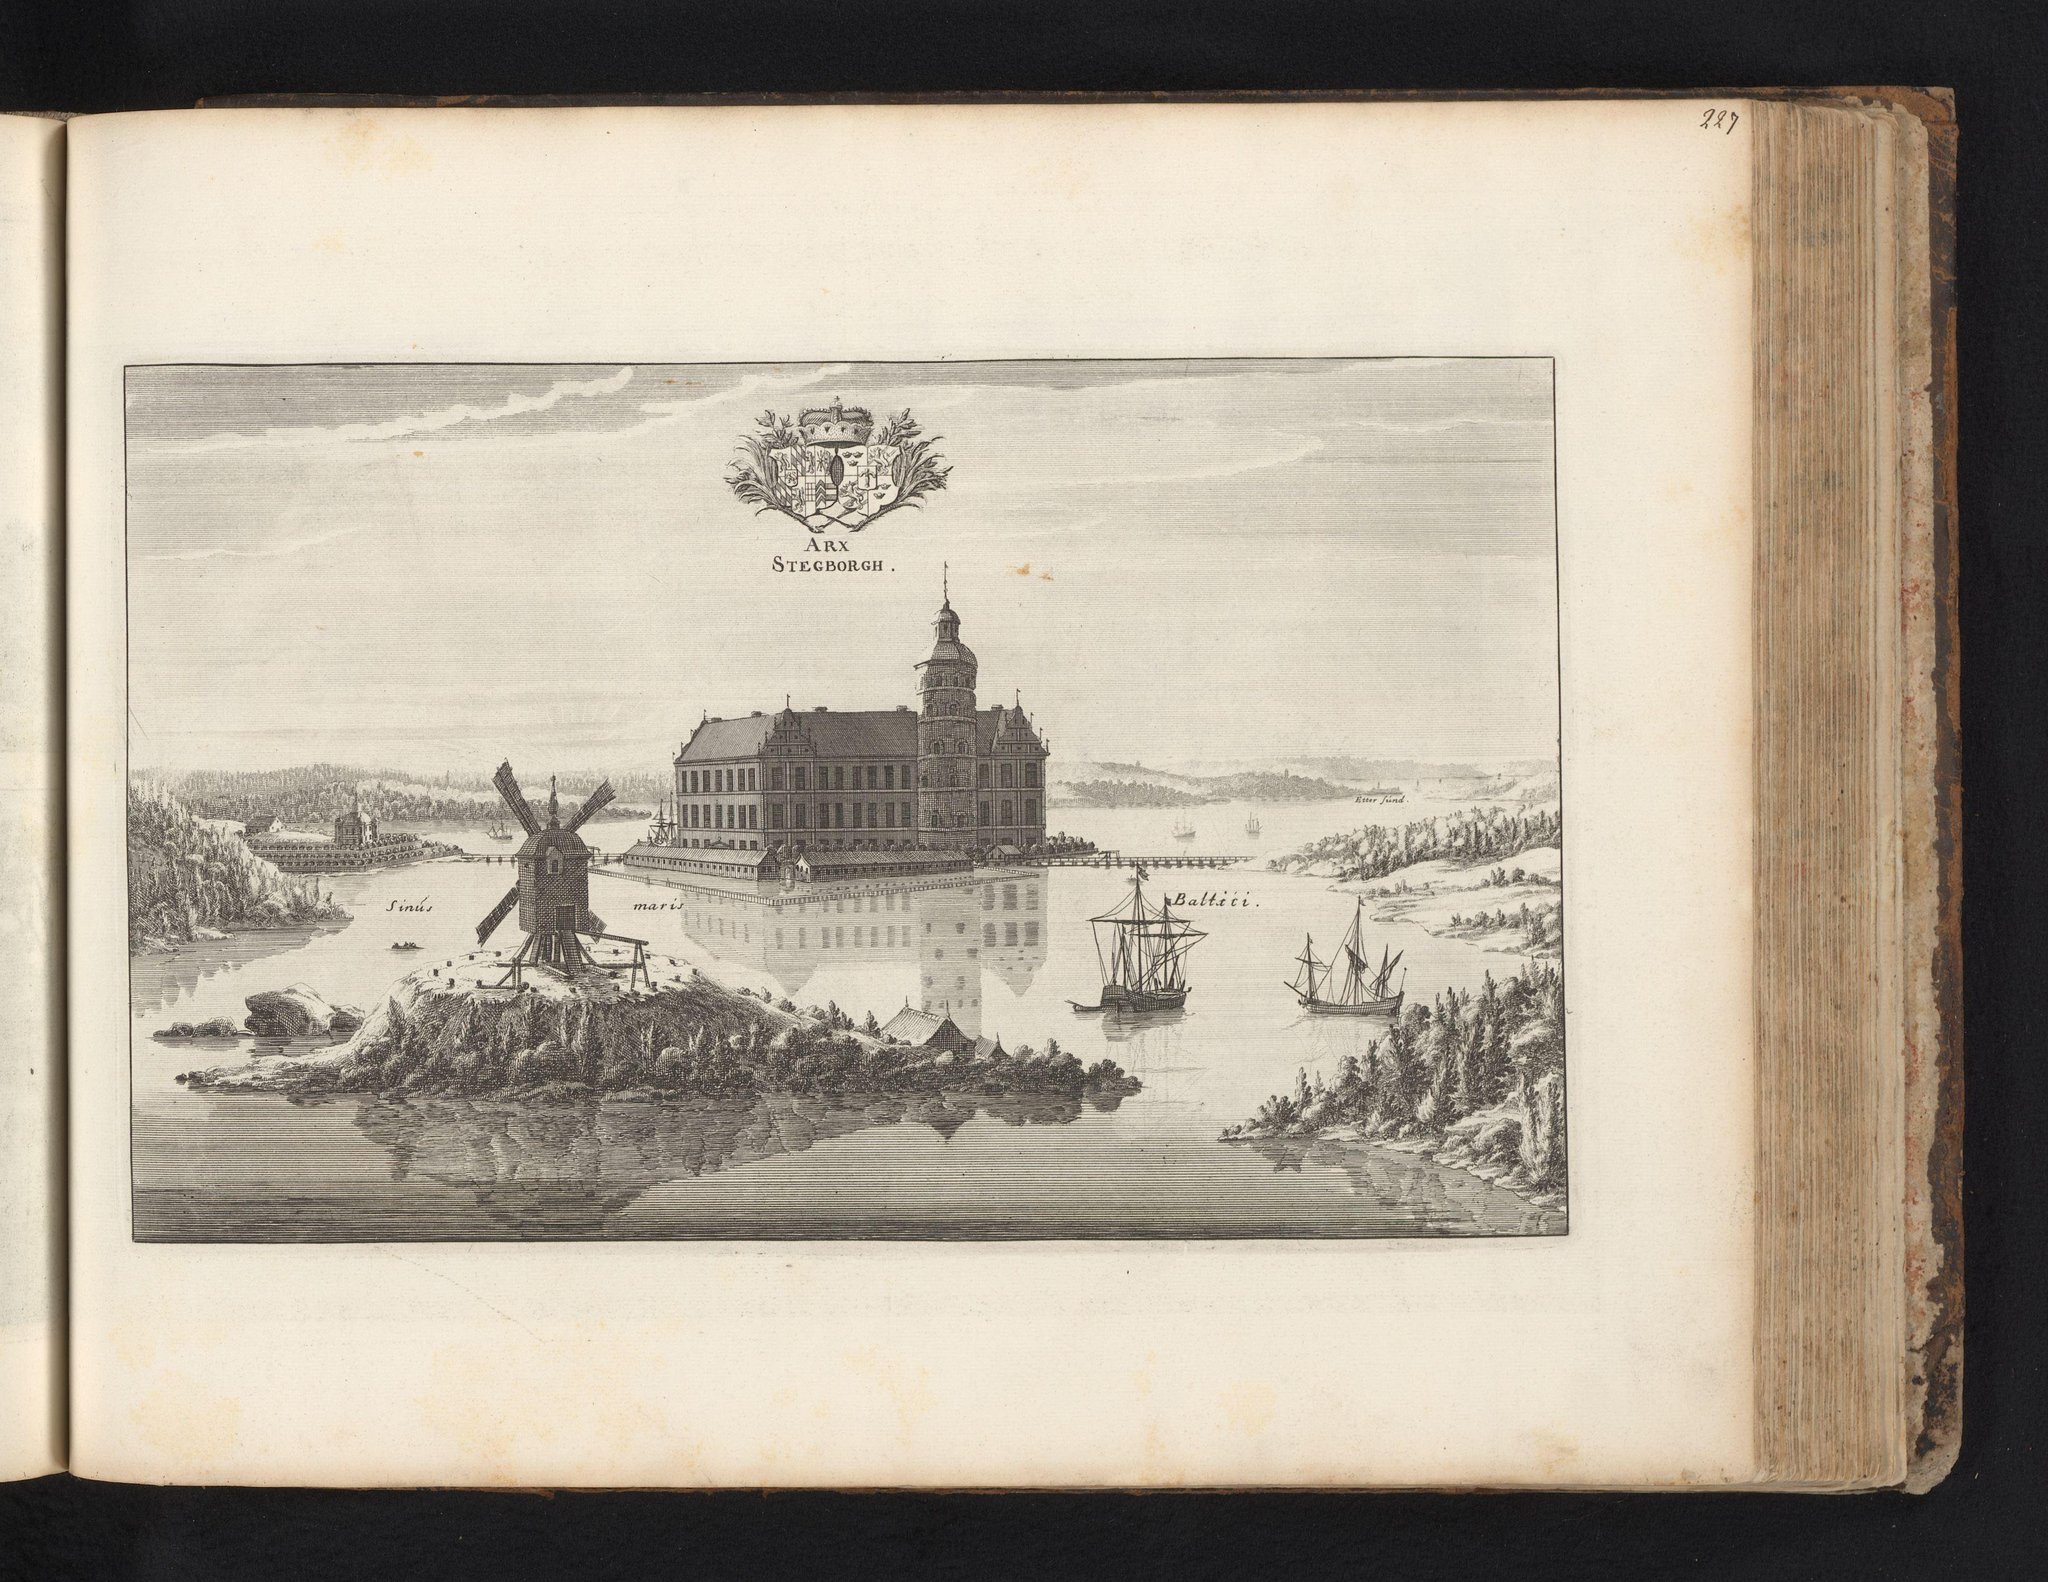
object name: print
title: Gezicht op slot Stegeborg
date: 1692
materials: paper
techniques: etching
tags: housing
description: Kungliga Biblioteket, 'Suecia': http://www.kb.se/samlingarna/Kartor-bilder/Suecia-antiqua/ (geraadpleegd november 2016).